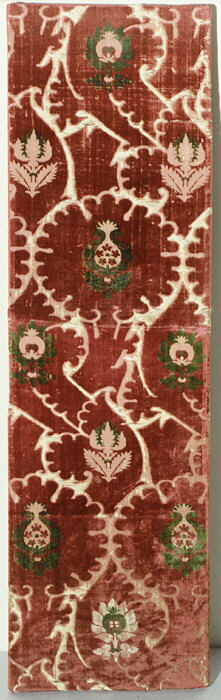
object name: piece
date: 1401-1500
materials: silk